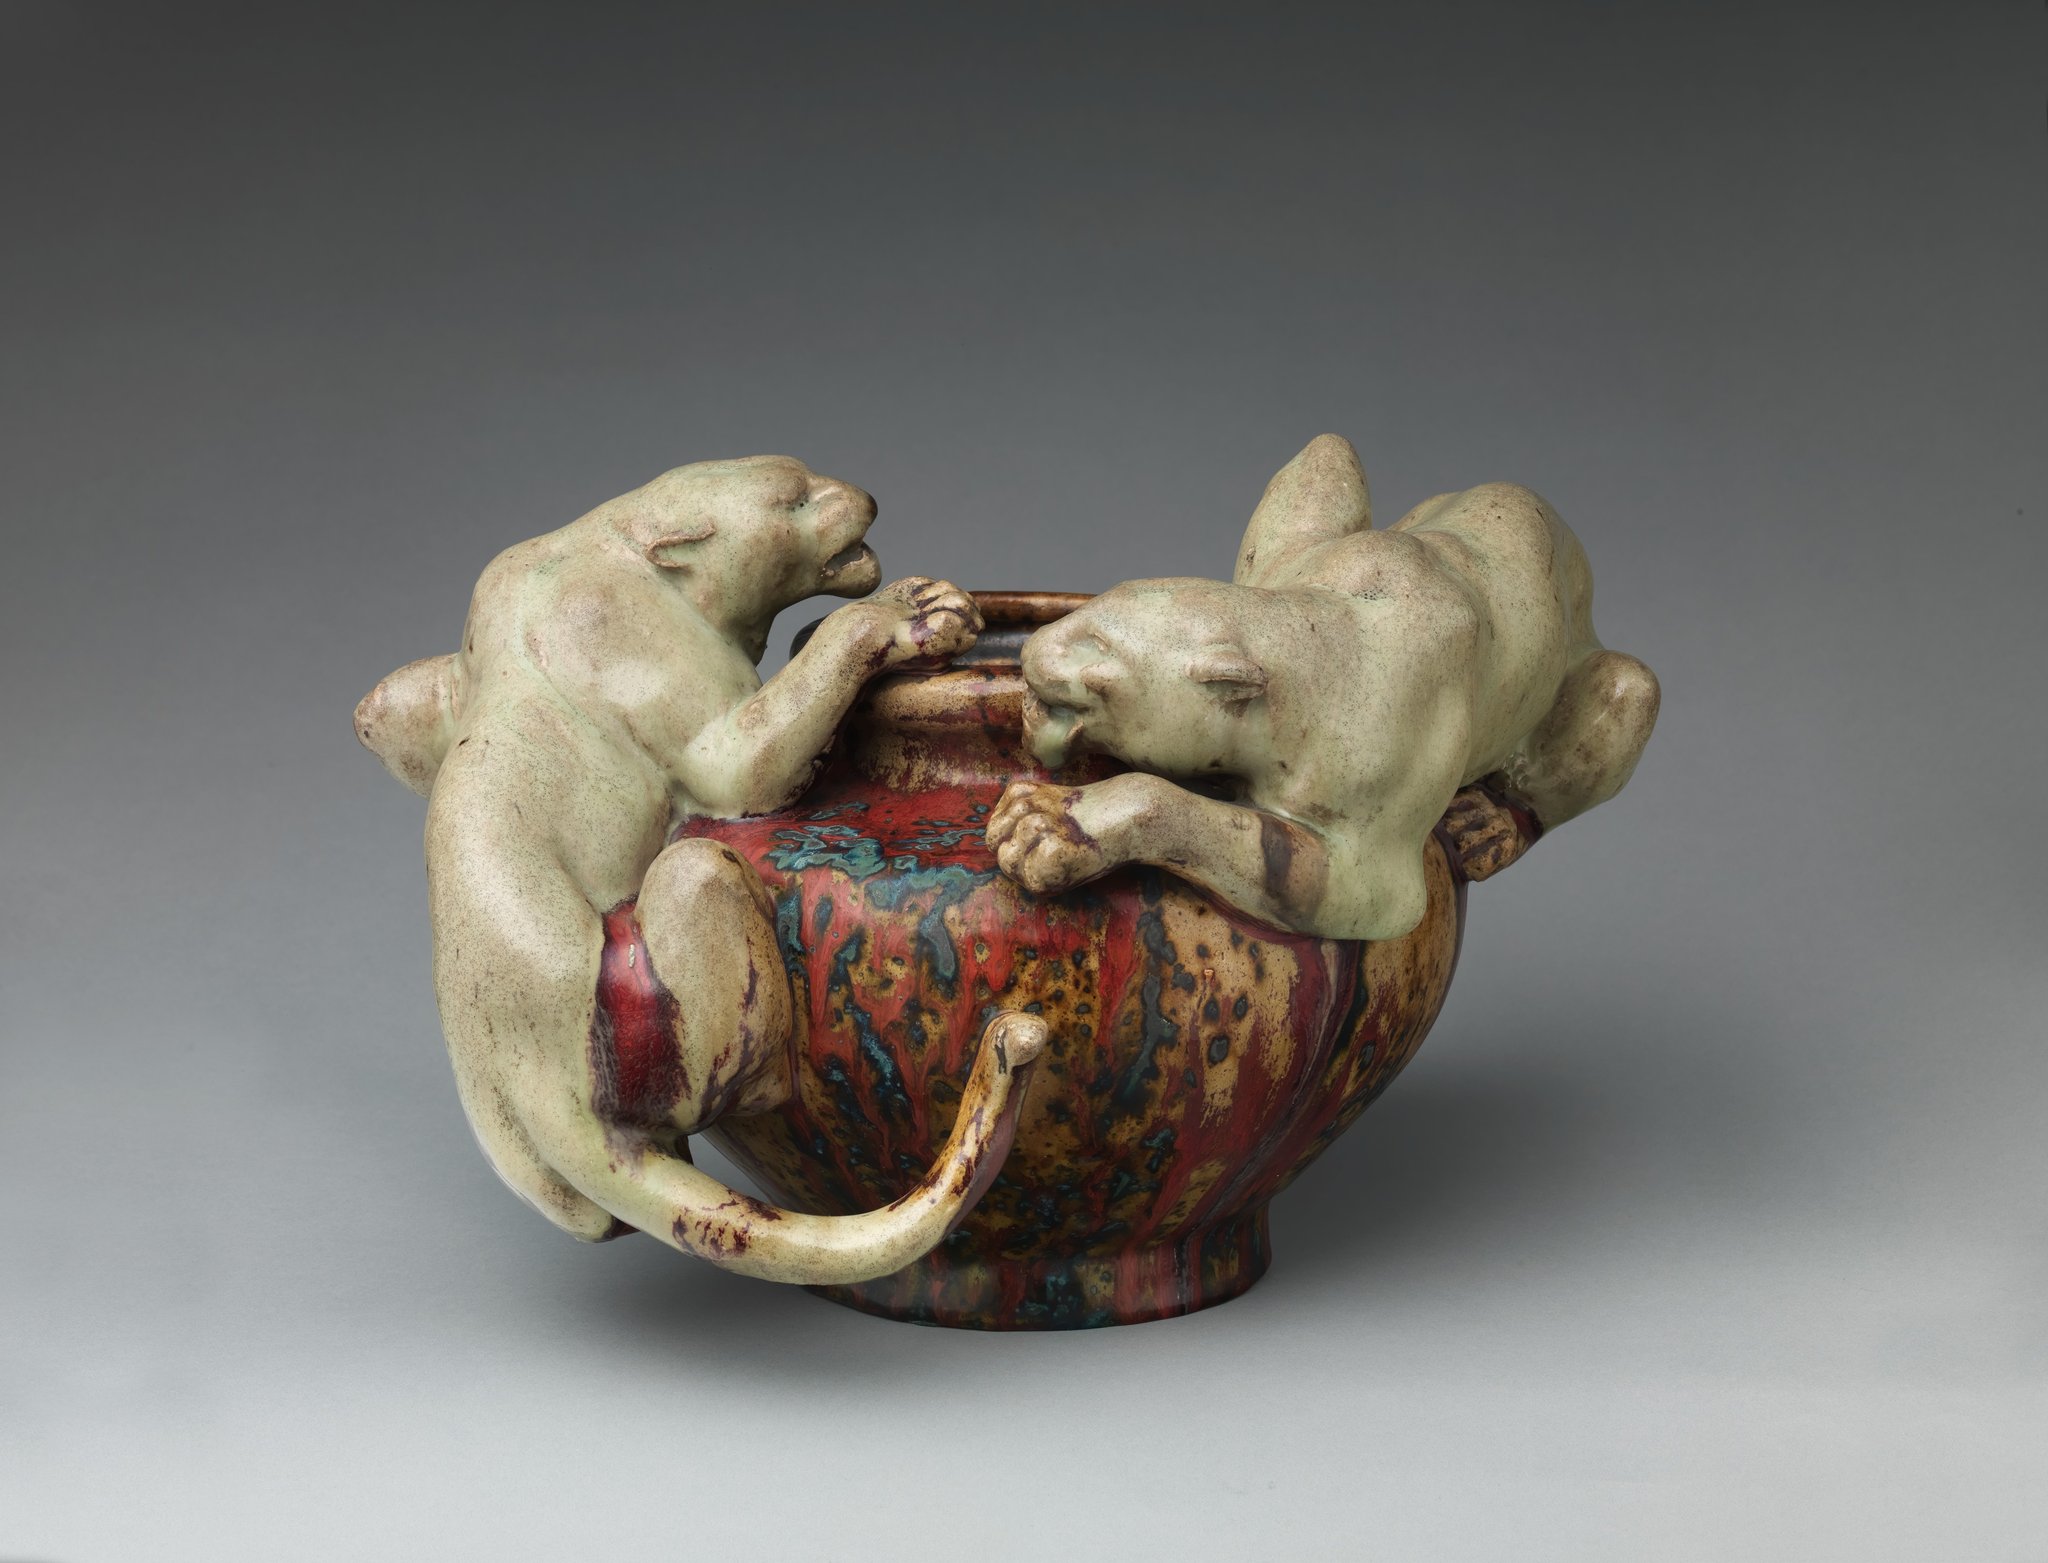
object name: bowl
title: Bowl with two panthers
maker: pierre-adrien dalpayrat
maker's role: maker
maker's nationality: french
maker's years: 1844-1910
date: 1894-1895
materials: stoneware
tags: animals